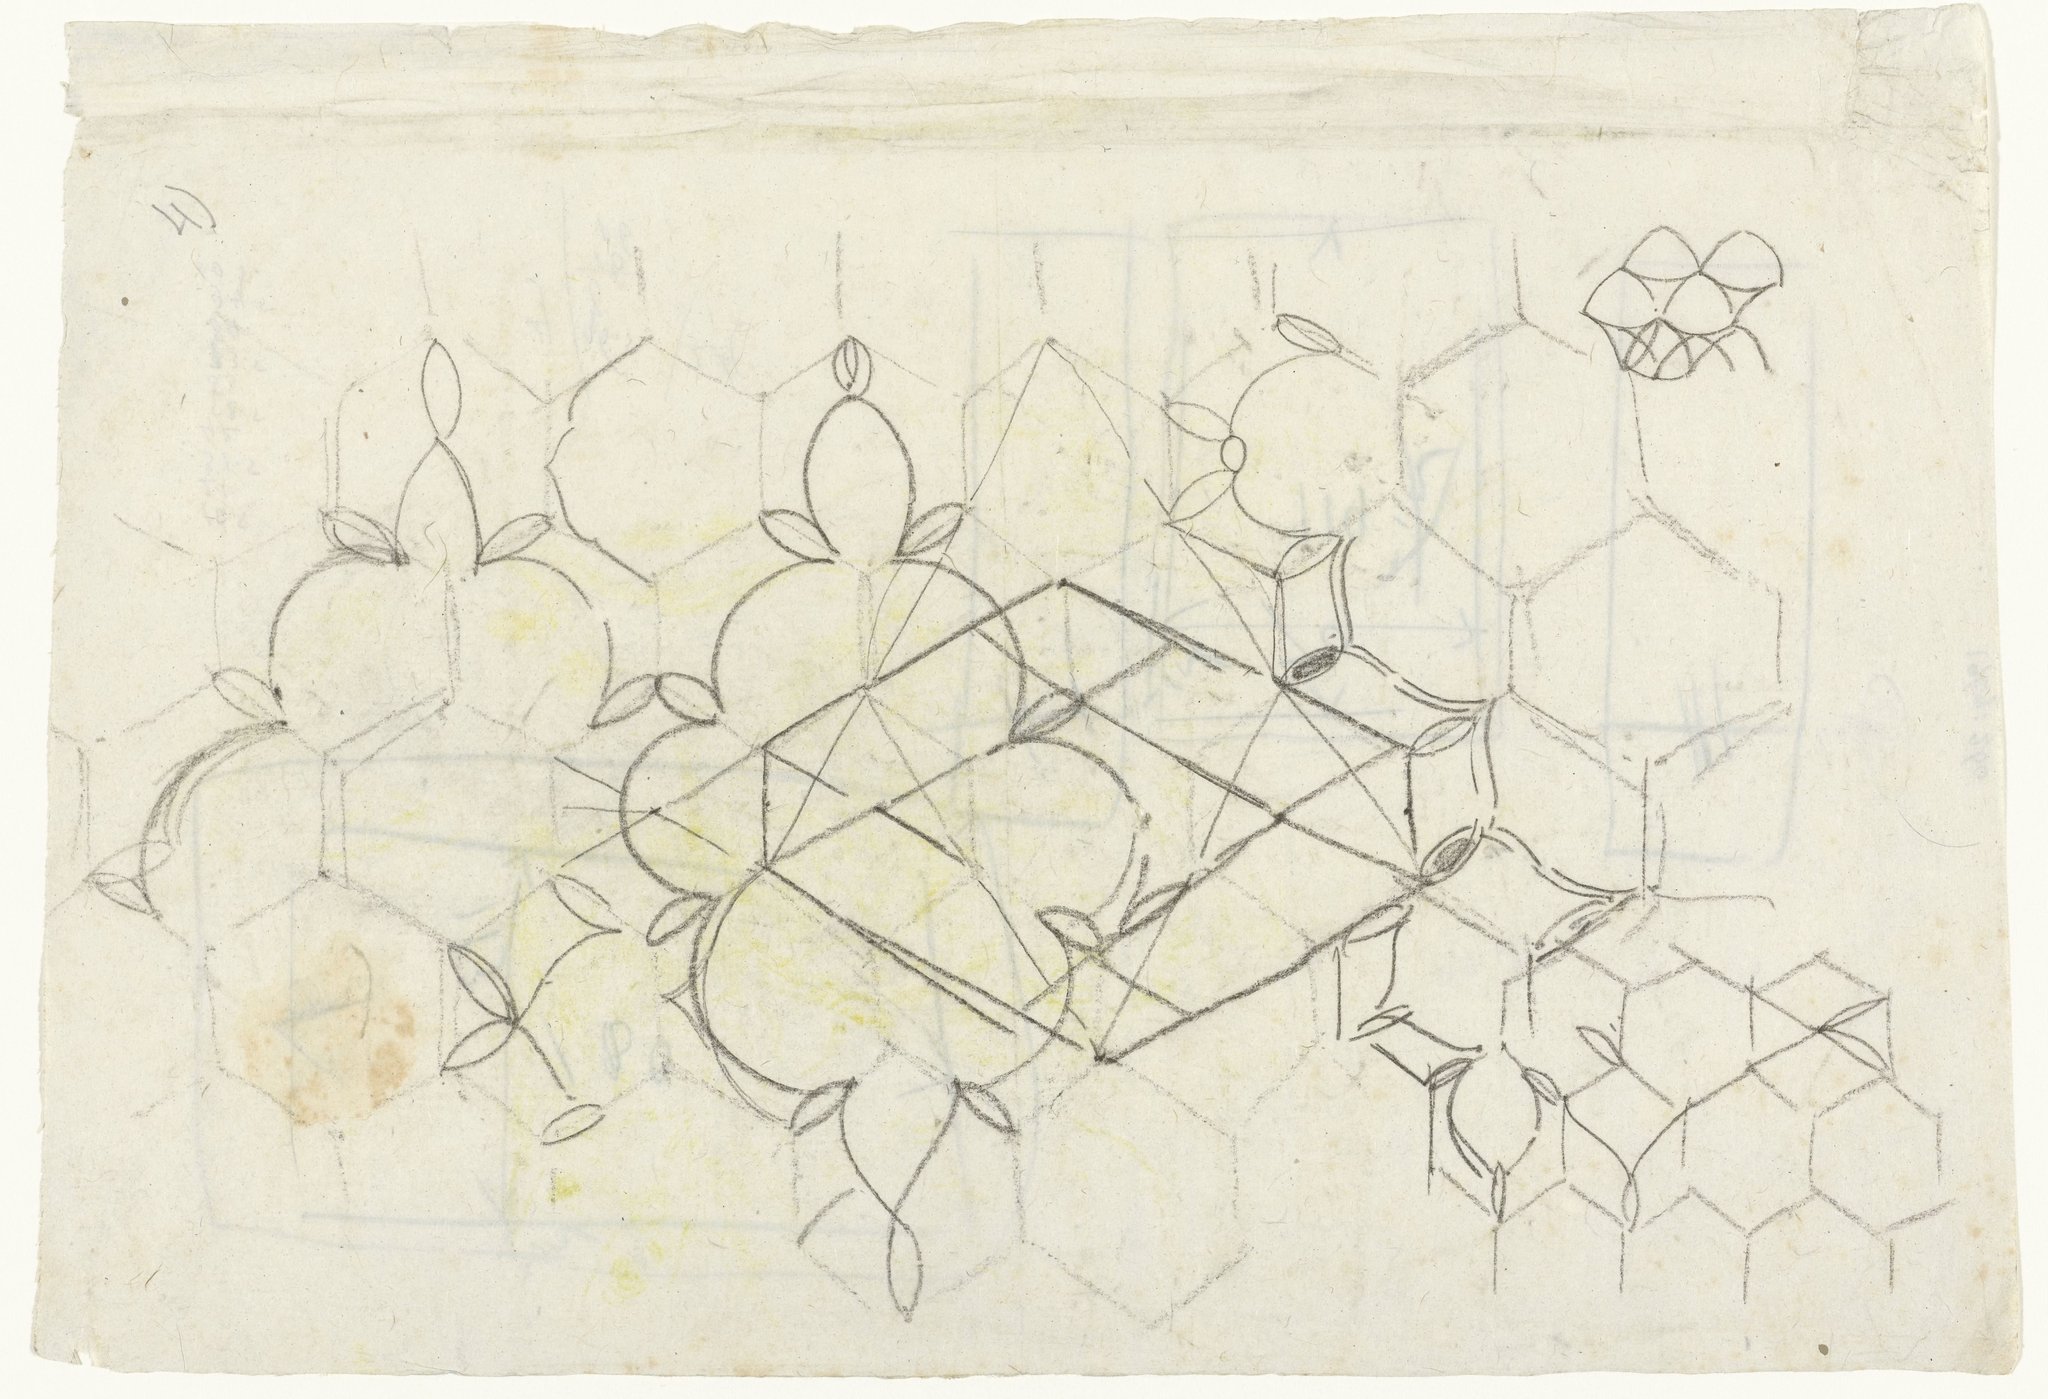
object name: drawing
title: Ontwerpen voor ornamenten met patroon van zeshoeken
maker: gerrit willem dijsselhof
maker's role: designer, draughtsman, print maker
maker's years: 1866-1924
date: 1876-1924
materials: chalk, paper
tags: ornaments ~ art